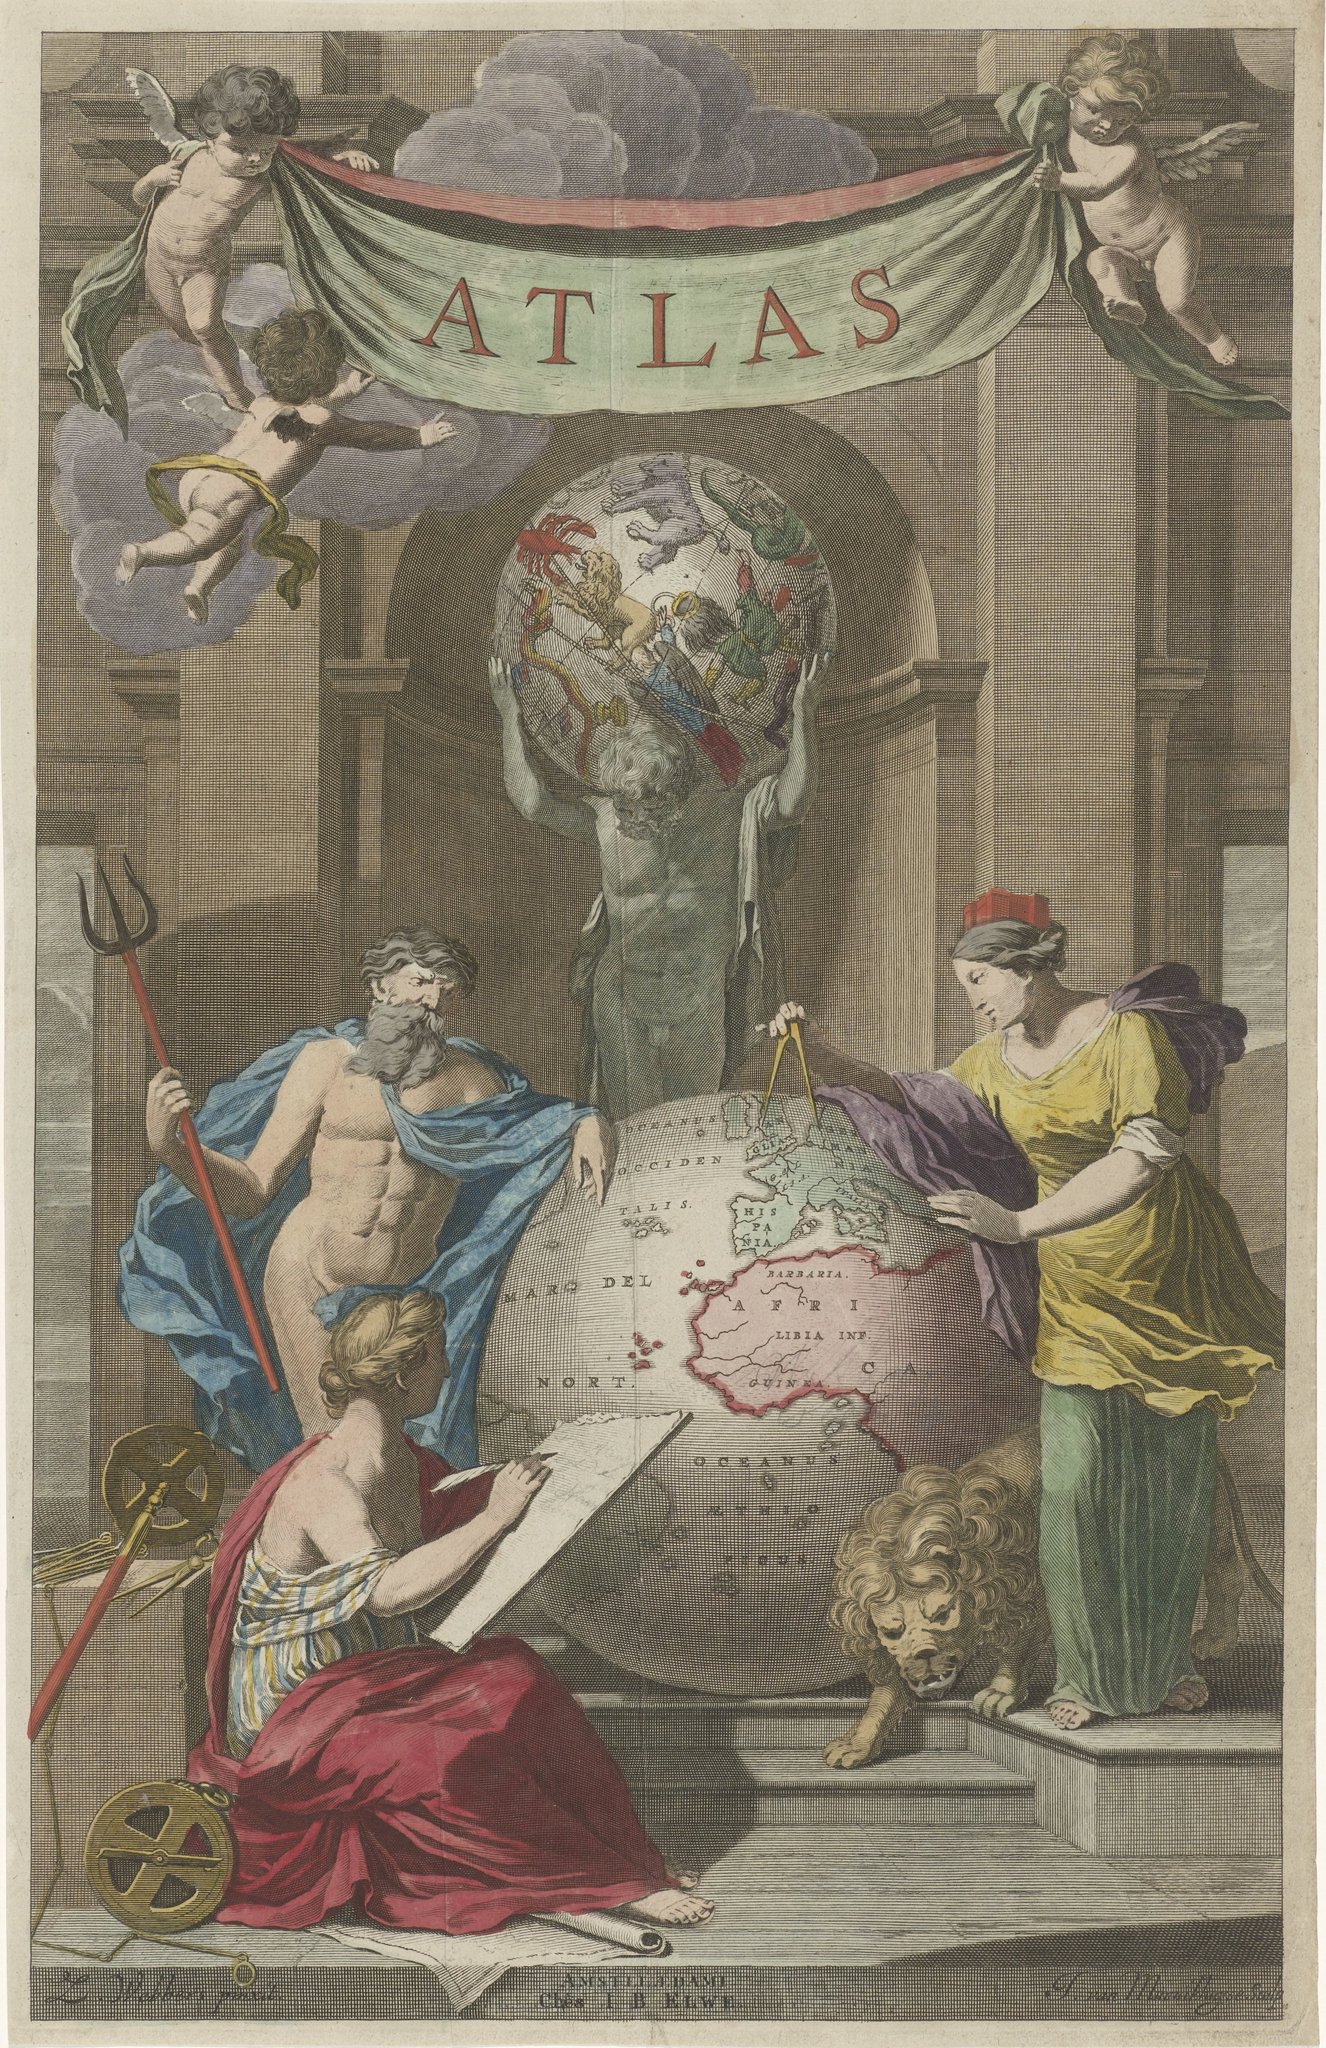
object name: titelblad, titelpagina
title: Neptunus en Cybele naast een globe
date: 1792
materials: paper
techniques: engraving, hand coloring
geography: amsterdam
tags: (story of) neptune (poseidon), 'geografia', (story of) cybele, rhea cybele, great mother of the gods (berecynt(h)ia), atlas supporting the heavens on his shoulders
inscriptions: collector's mark: Lugt 2228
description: Neptunus, de god van de zee, wijst op het water en Cybele, de godin van de aarde, meet het land van een globe. Op de voorgrond zit Geografie met een tablet en pen in de hand naast allerlei landmeetinstrumenten. Op de achtergrond draagt Atlas de aarde. Titelpagina voor een atlas.